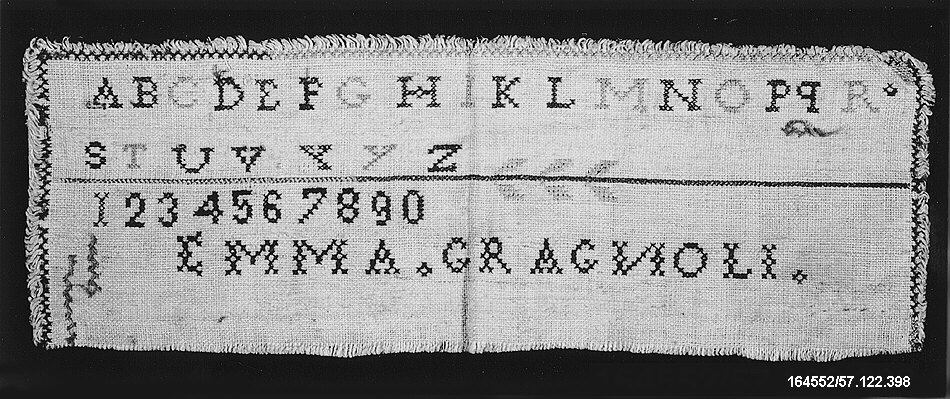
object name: sampler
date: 1801-1900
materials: cotton, linen, silk, wool